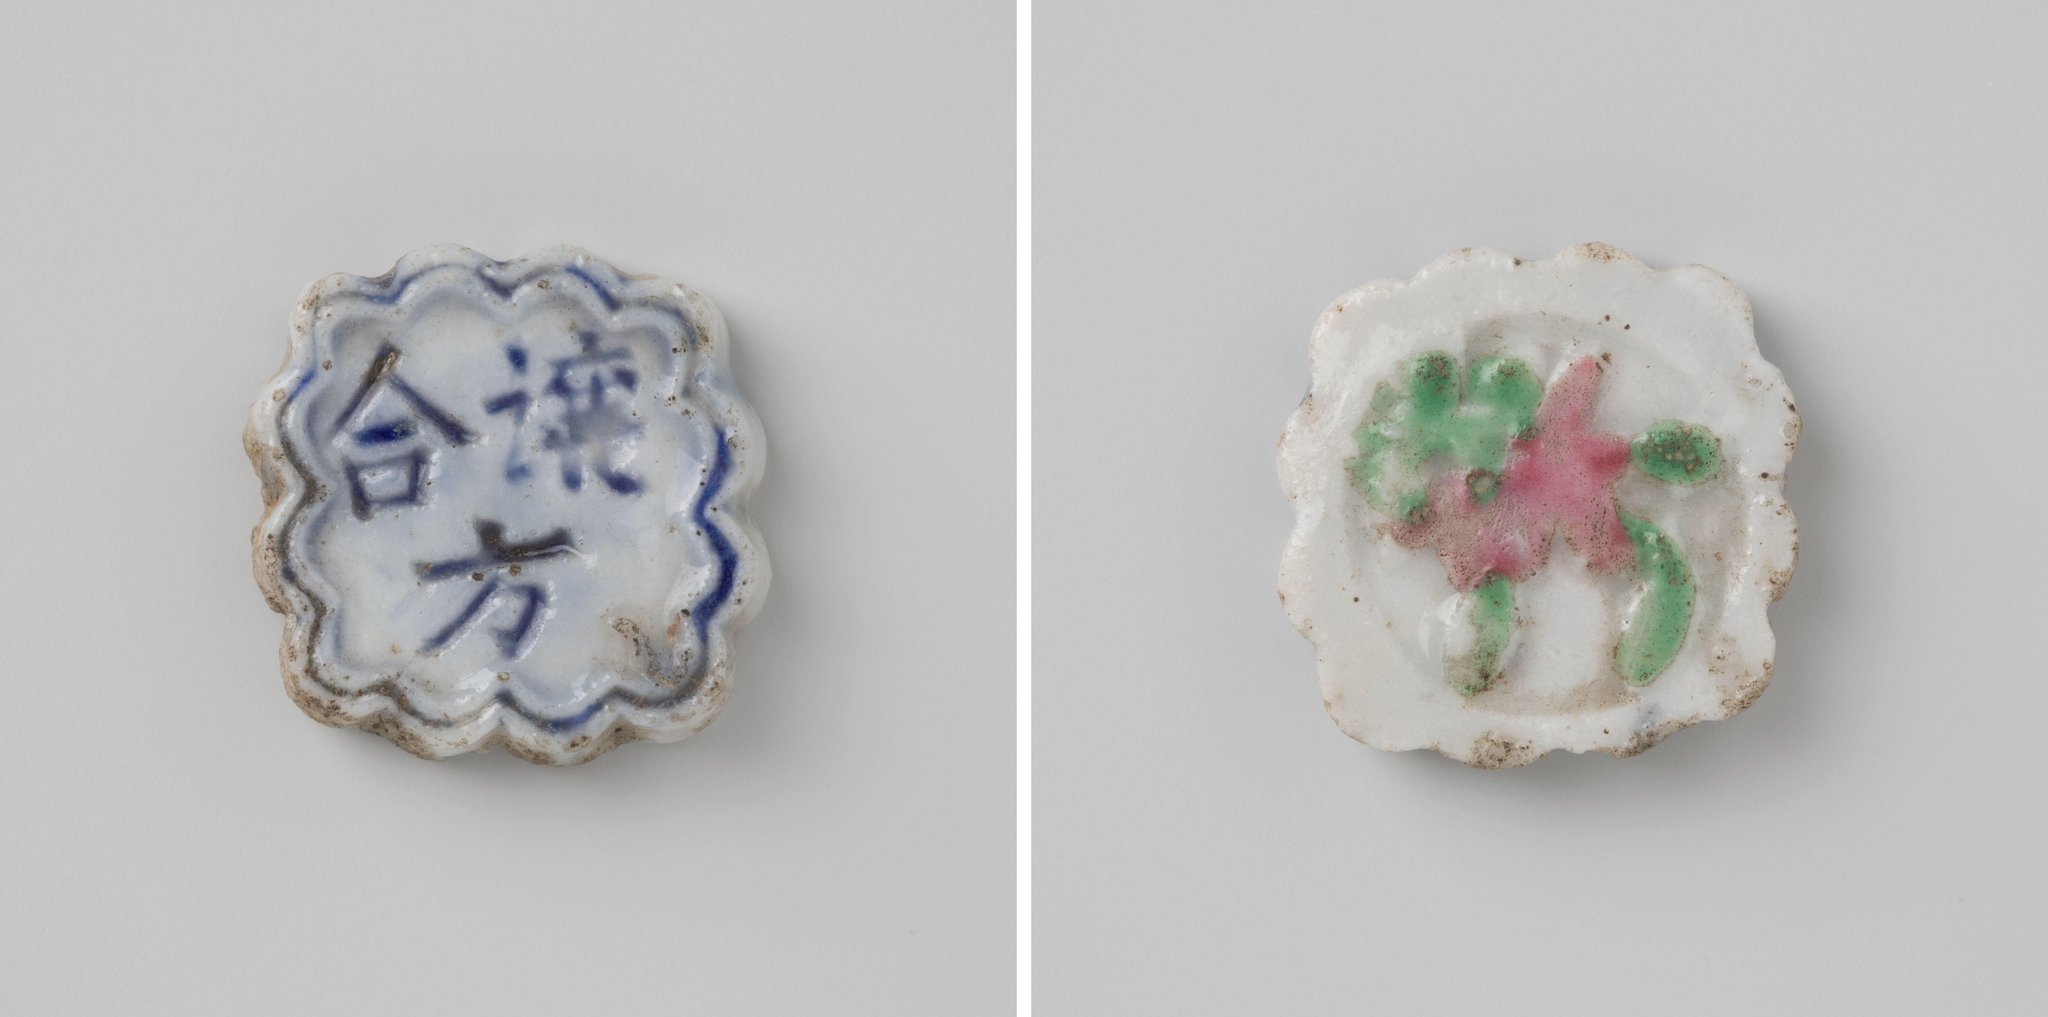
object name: coin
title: Thailand, speelhuispenning uitThailand ter waarde van een fuang, 1760-1871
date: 1760-1871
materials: porcelain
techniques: firing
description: Vierkanten, gekartelde porseleinen speelhuispenning, die ook als munt is gebruikt. Voorzijde: drie Chinese karakters. Keerzijde: afbeelding.